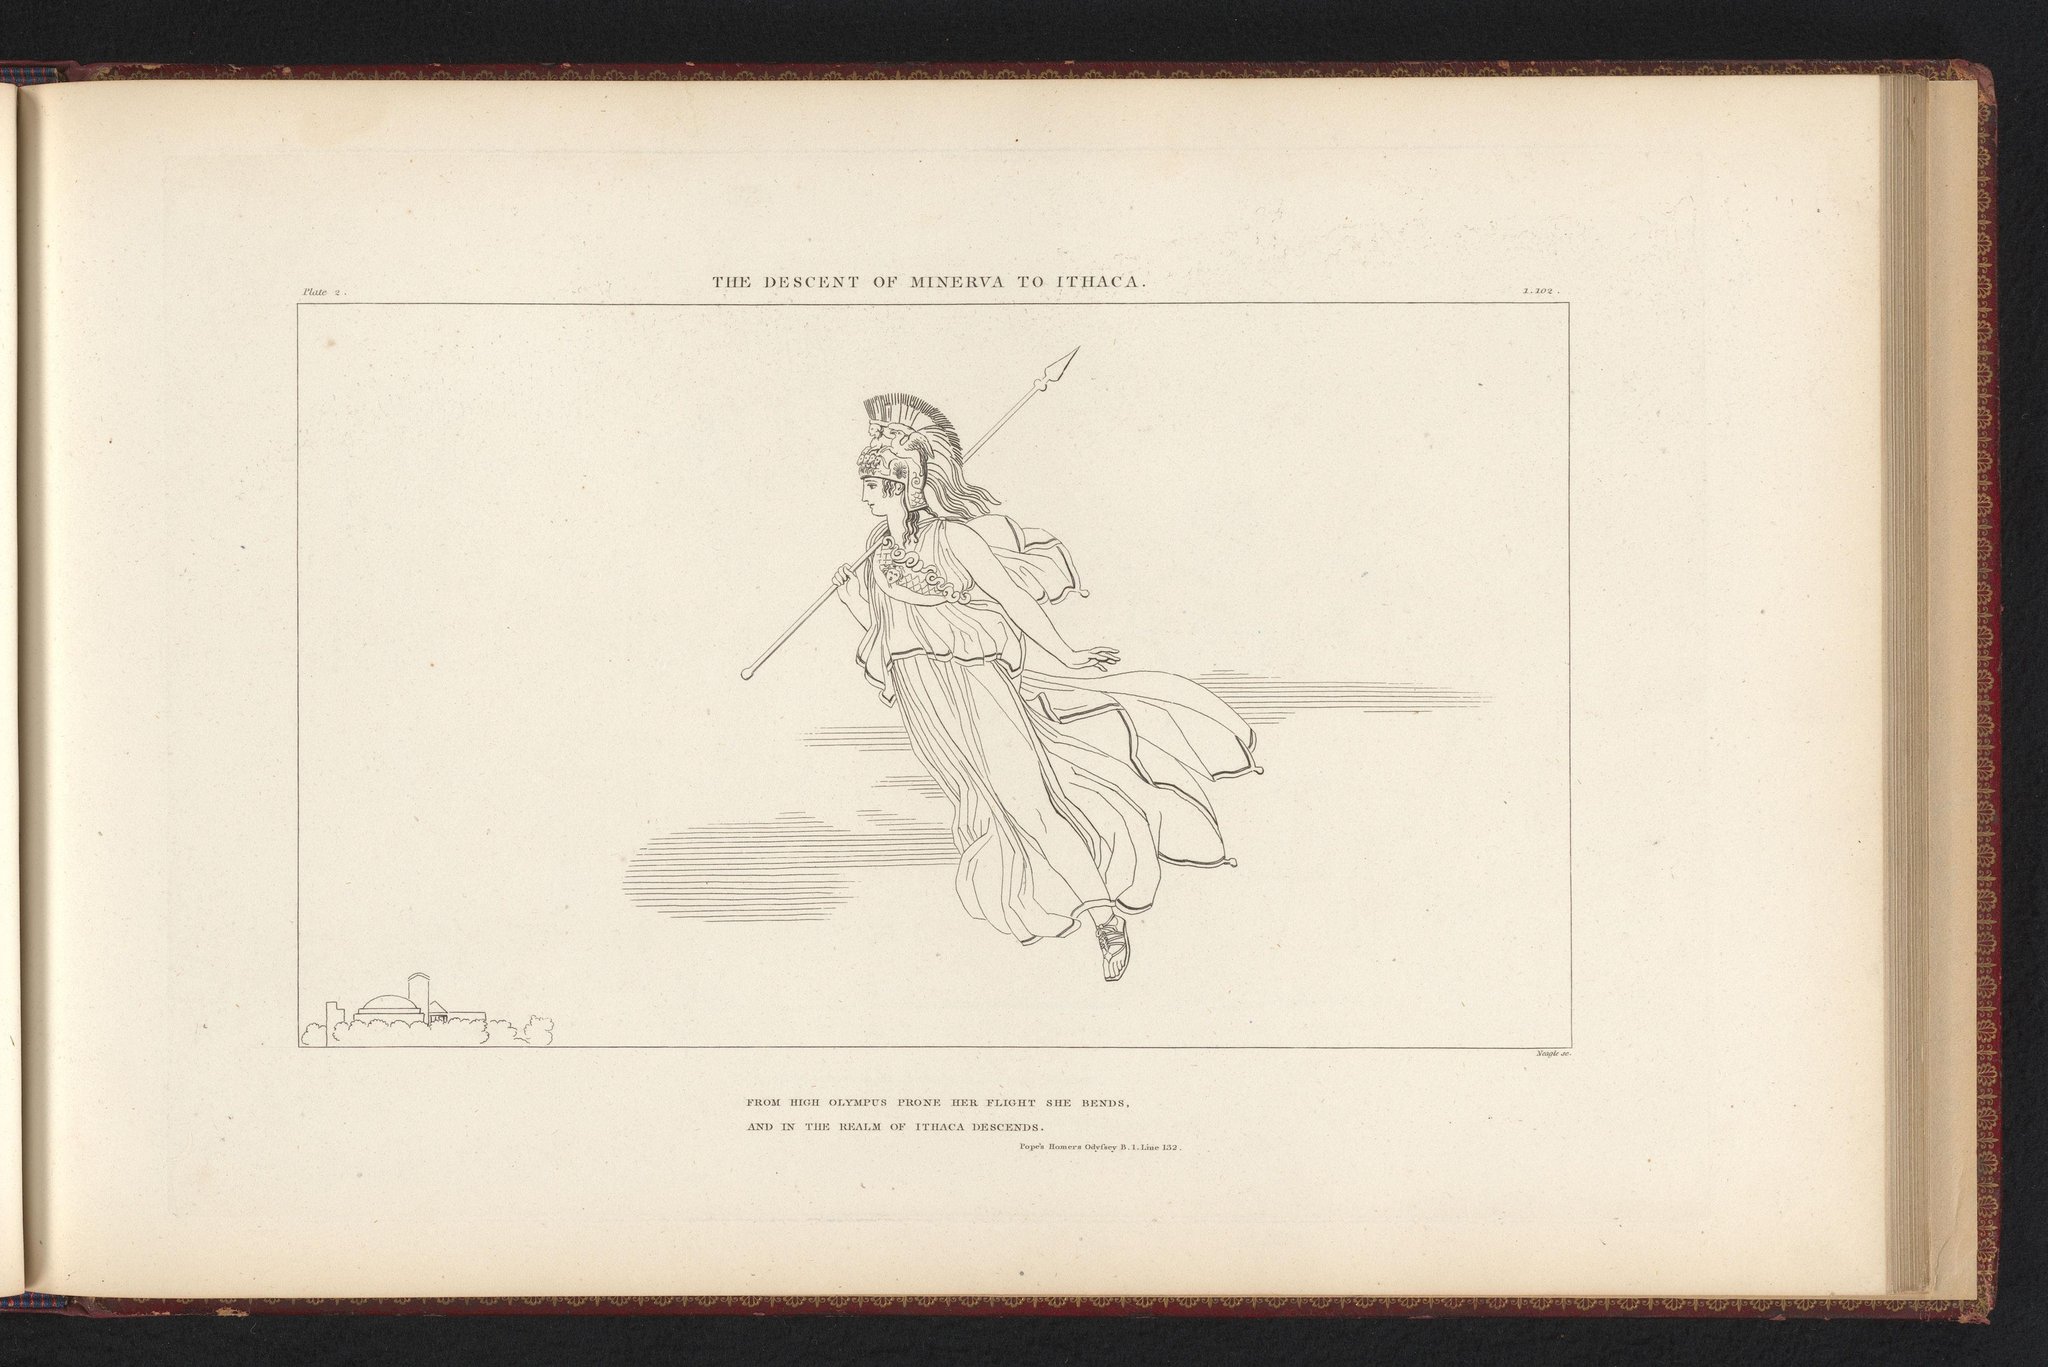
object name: album leaf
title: Odyssey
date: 1805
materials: paper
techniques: etching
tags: (story of) minerva (pallas, athena)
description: Prent maakt onderdeel uit van een serie met 34 prenten over de Odyssee, geschreven door Homerus.